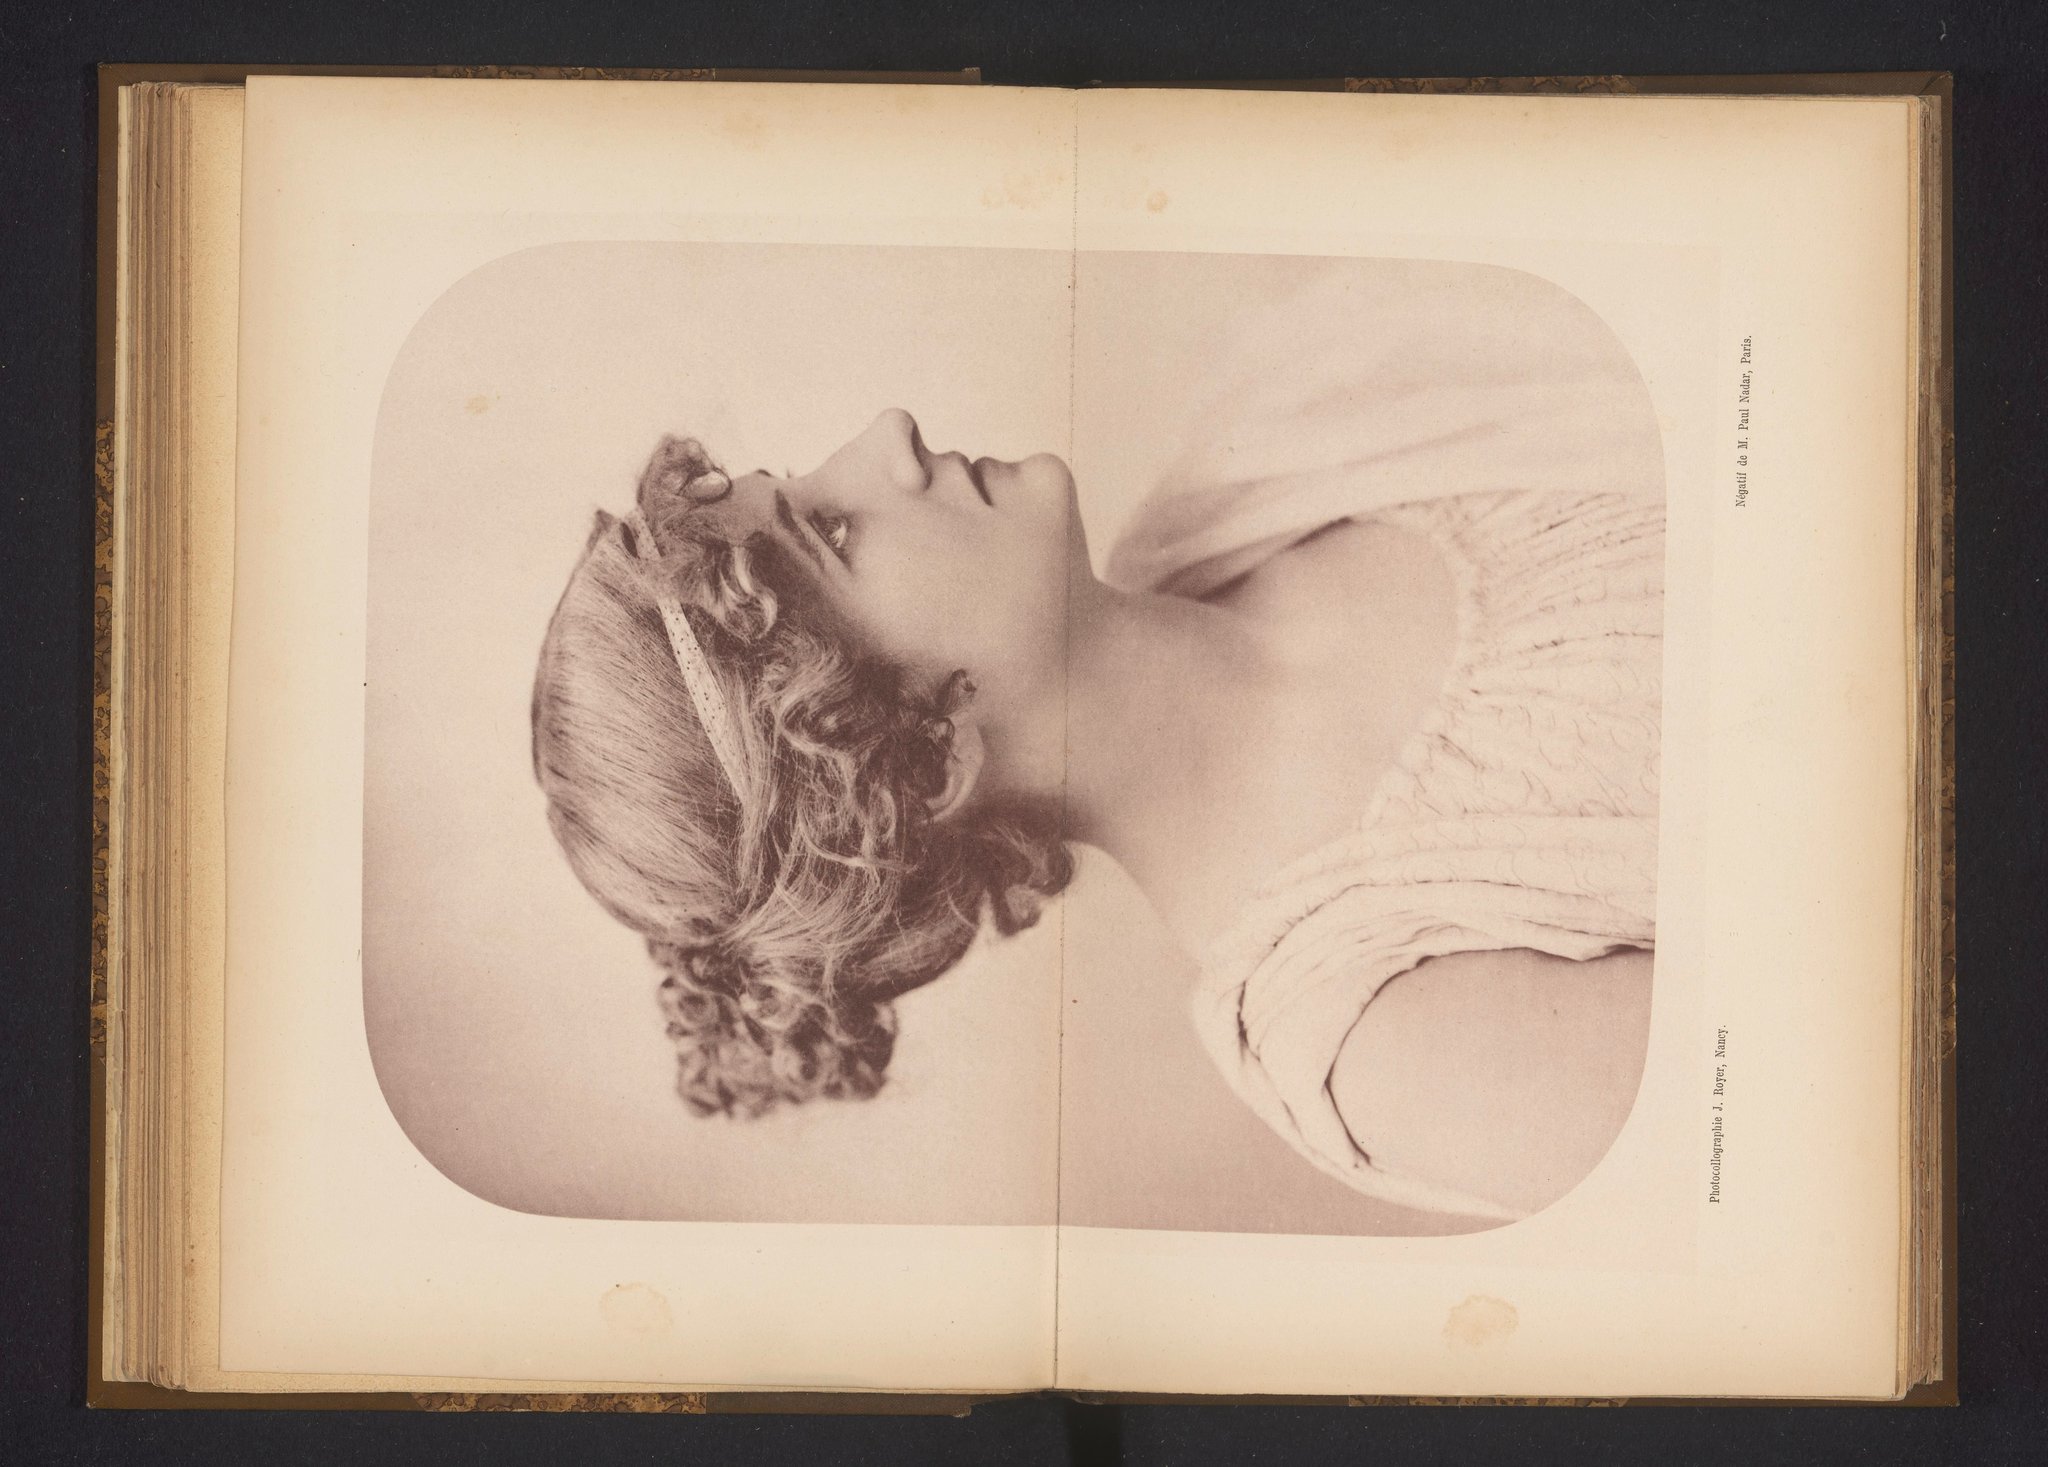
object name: photomechanical print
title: Portret van een onbekende vrouw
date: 1887-1892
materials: paper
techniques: photograph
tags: adult woman, historical persons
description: Prent op tweede en derde pagina na pagina 124.